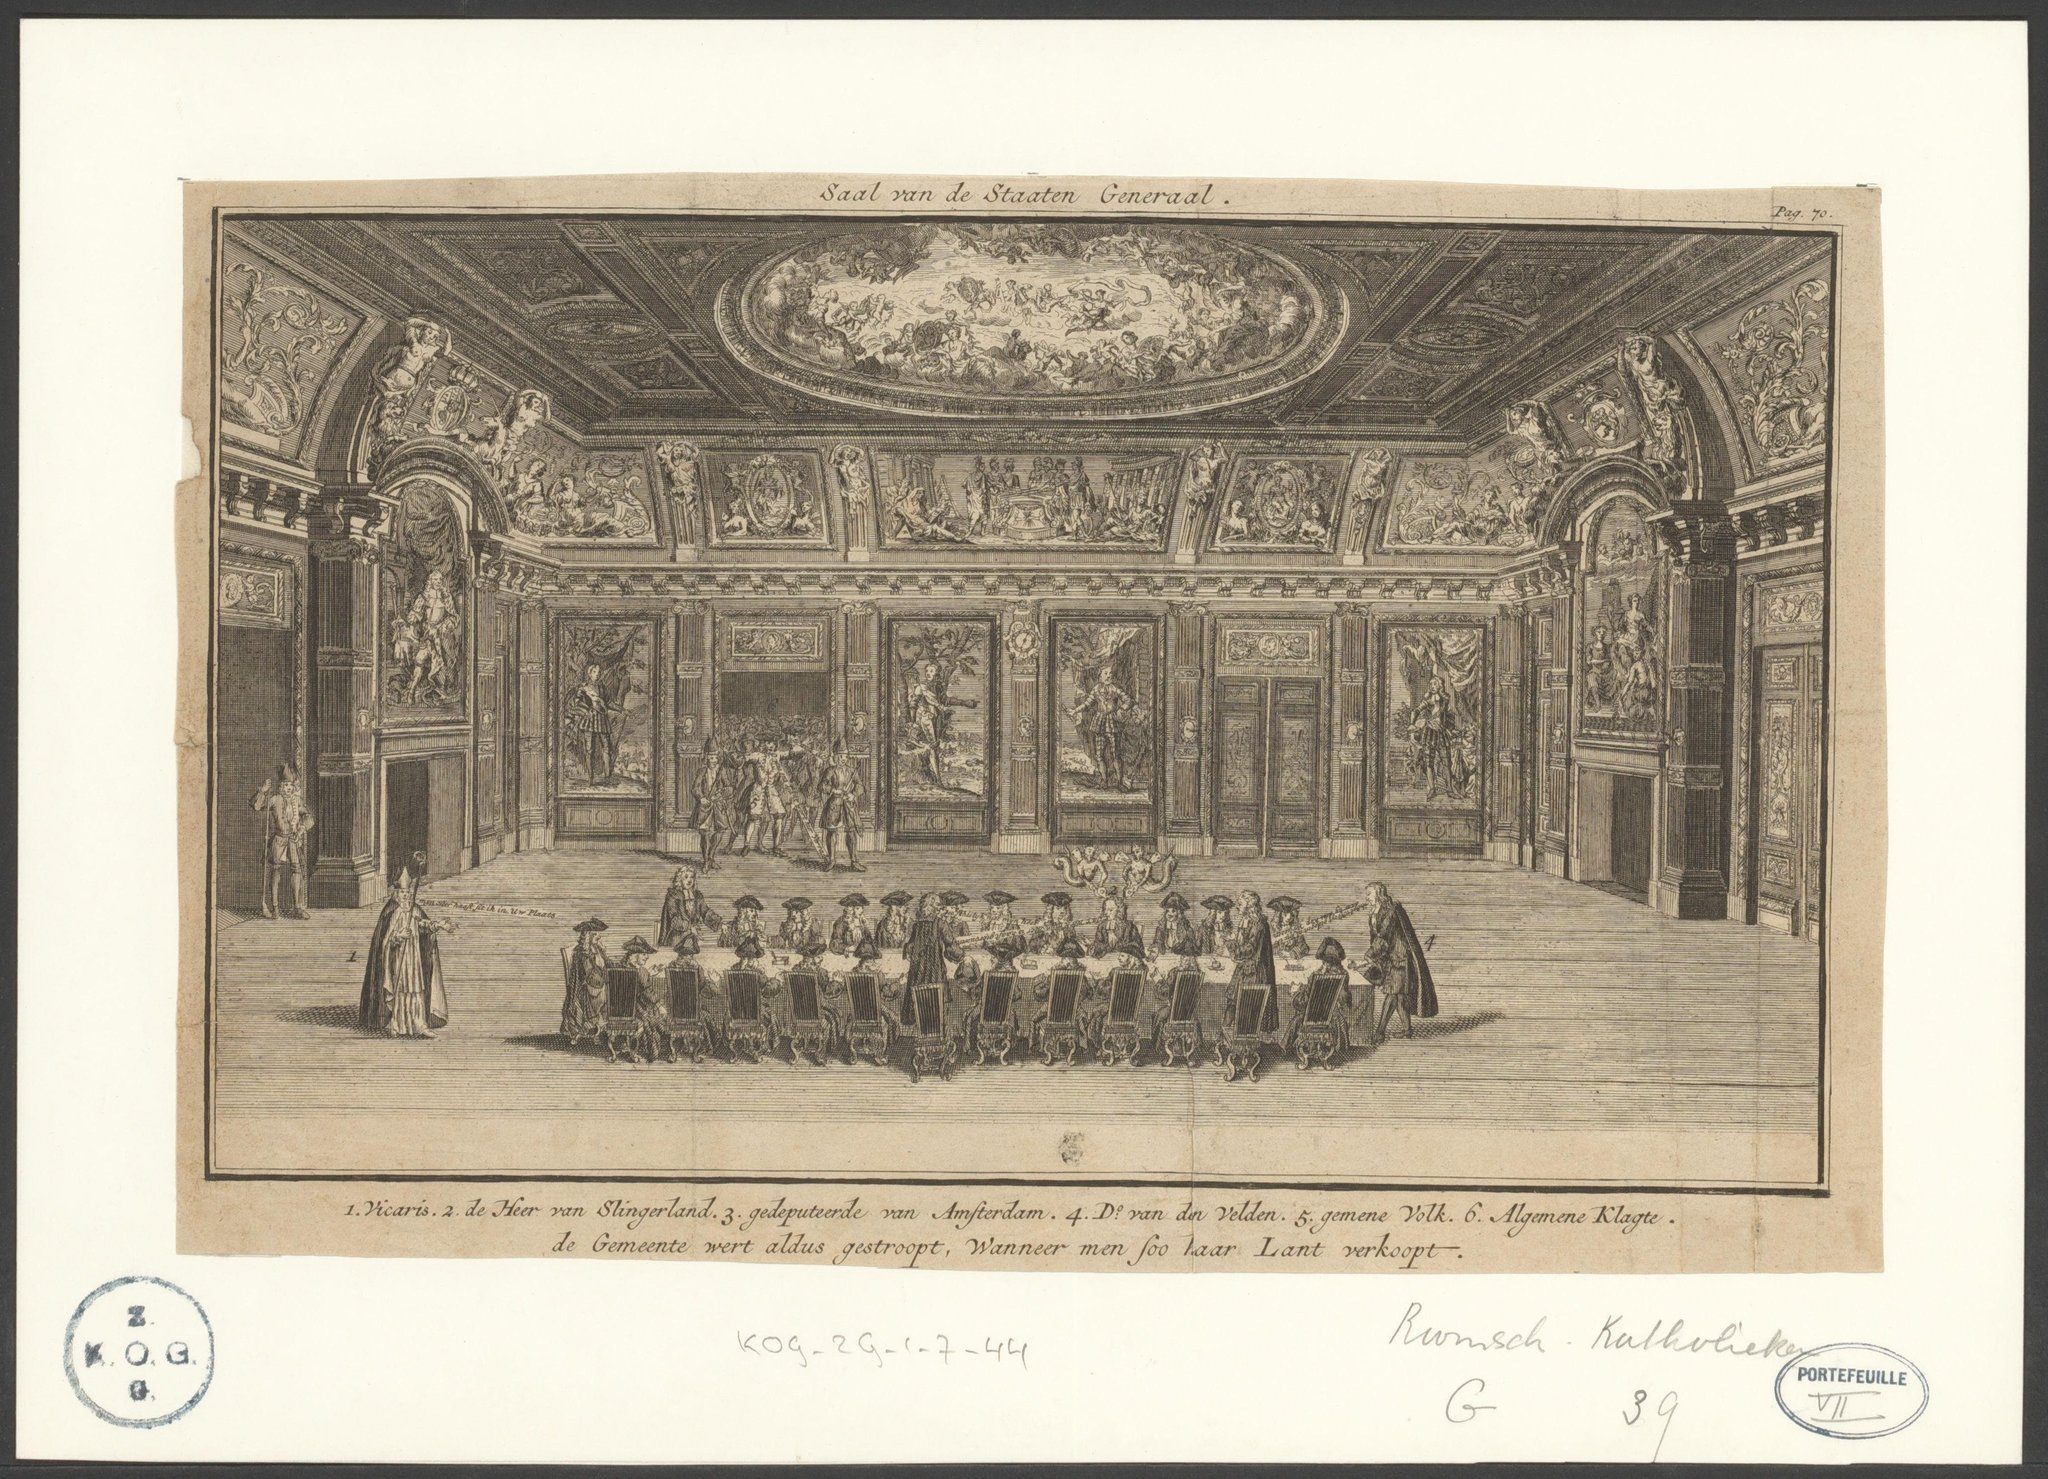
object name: book illustration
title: Saal van de Staaten Generaal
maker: Anonymous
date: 1732-1734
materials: paper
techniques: engraving, etching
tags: national government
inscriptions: stamp, collector's mark: Lugt 1641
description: Overleg door de Staten-Generaal in de Trêveszaal over het aanstellen van een Roomse vicaris in Nederland, 30 april 1732. Voorstelling met allegorische elementen. In het onderschrift de verklaring van de cijfers 1-6. Rechtsboven genummerd: Pag. 70. Onderwerpsrubrieken binnen de Atlas Zeden en Gewoonten: Godsdienst, Roomsch-Katholieken, Processies, Herinneringen.